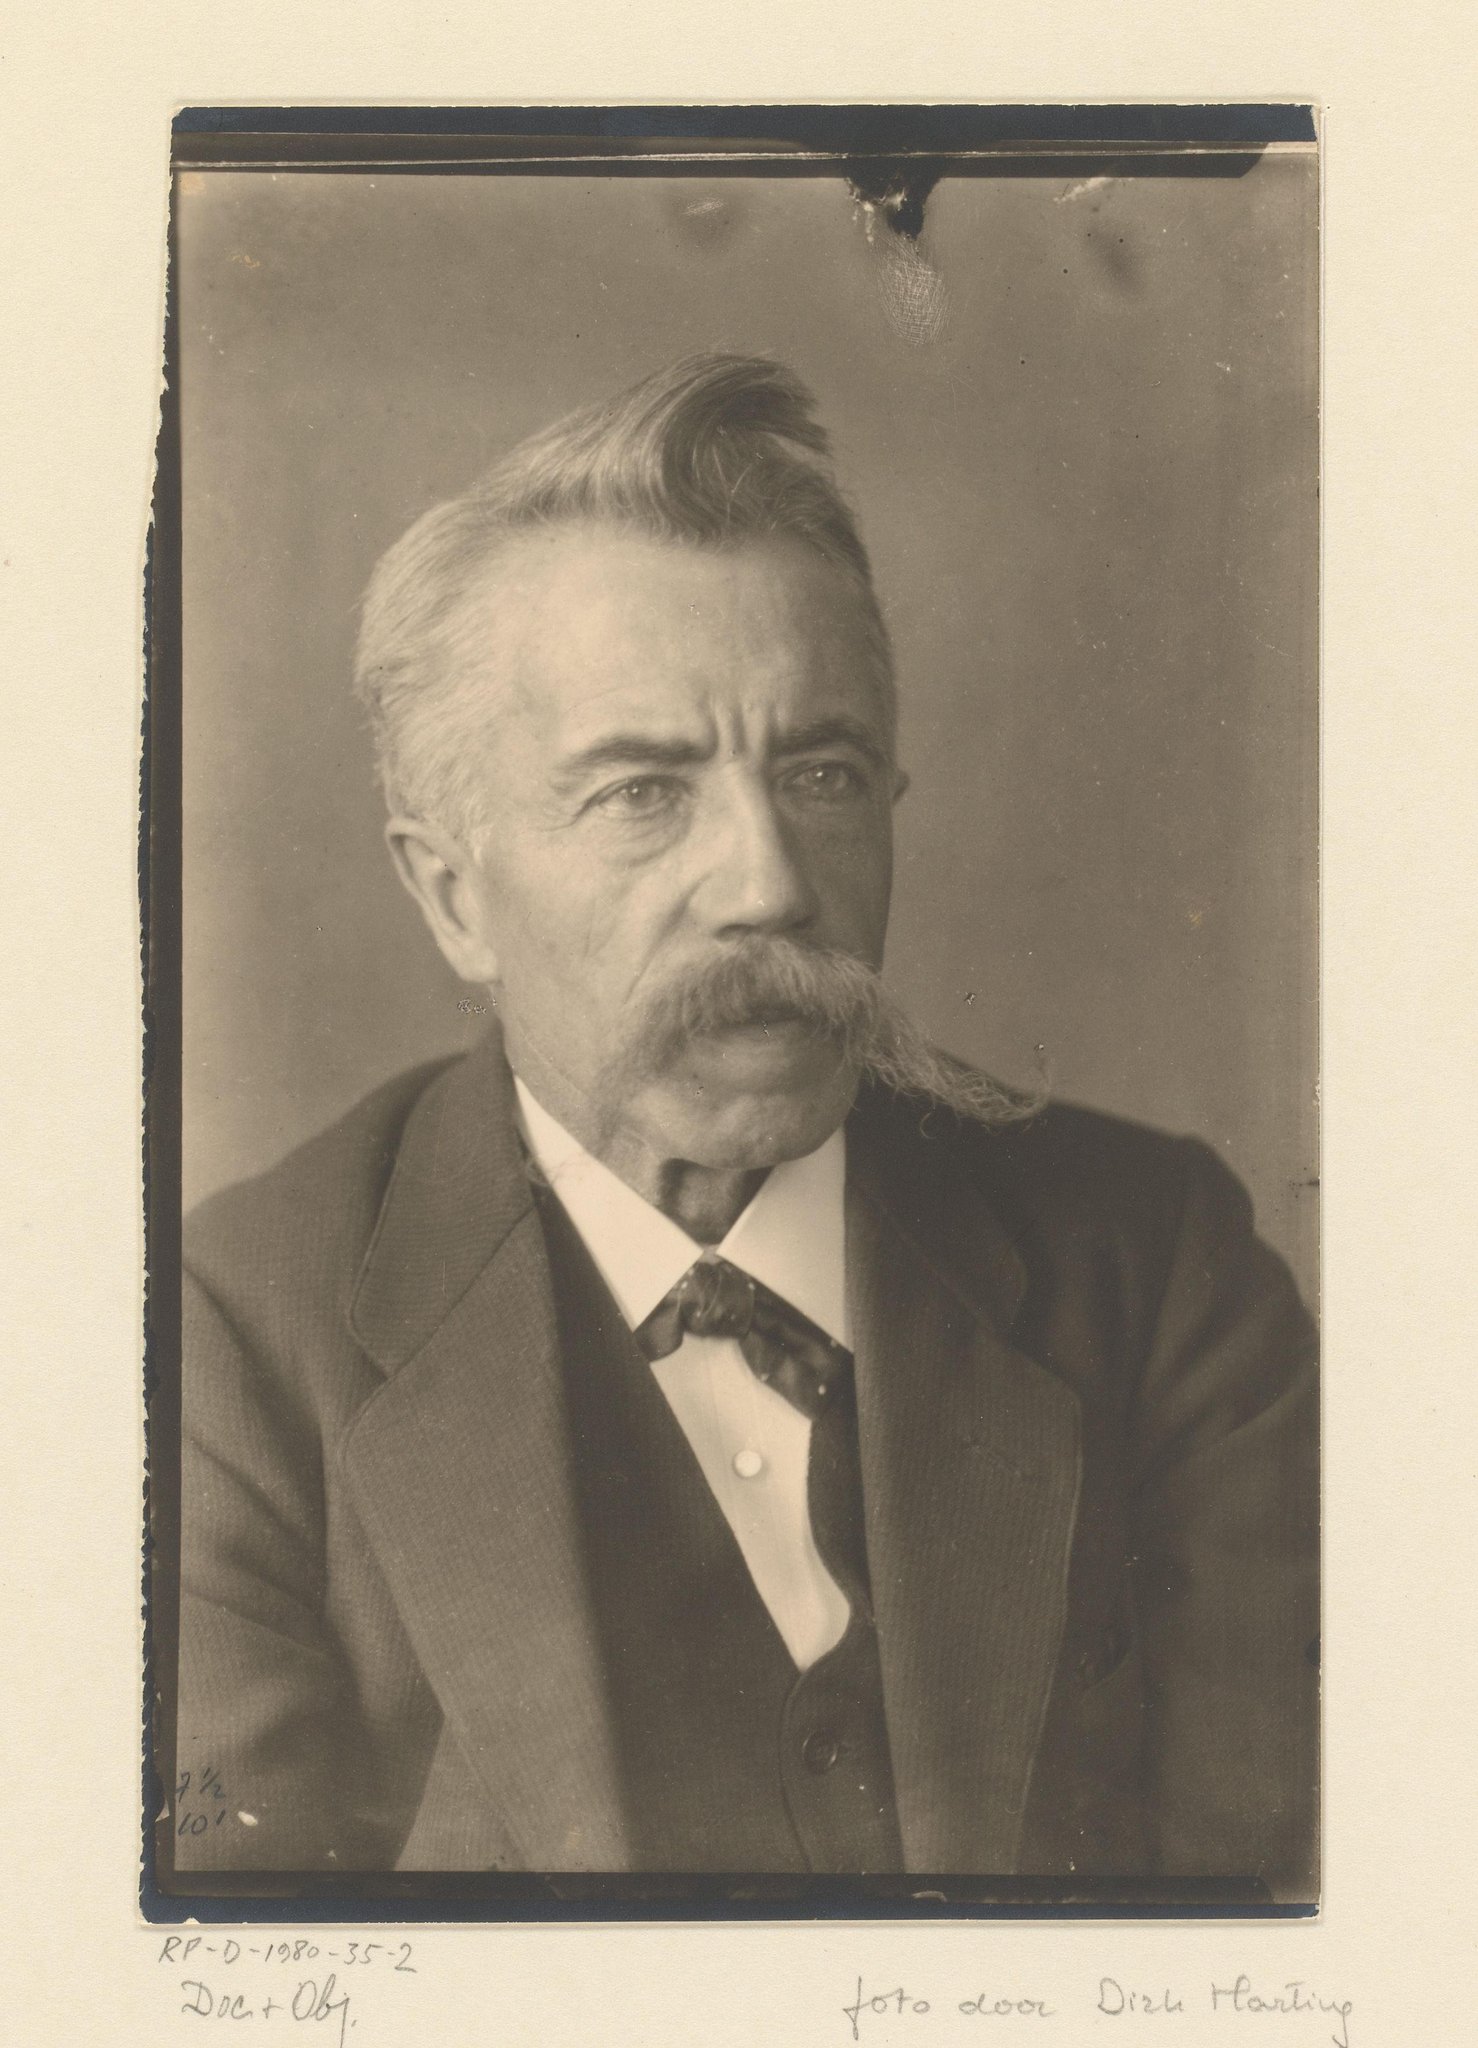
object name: photograph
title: Portret van Eduard Karsen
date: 1910-1930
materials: paper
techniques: gelatin silver print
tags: painter, print maker, draughtsman, eduard karsen, historical persons